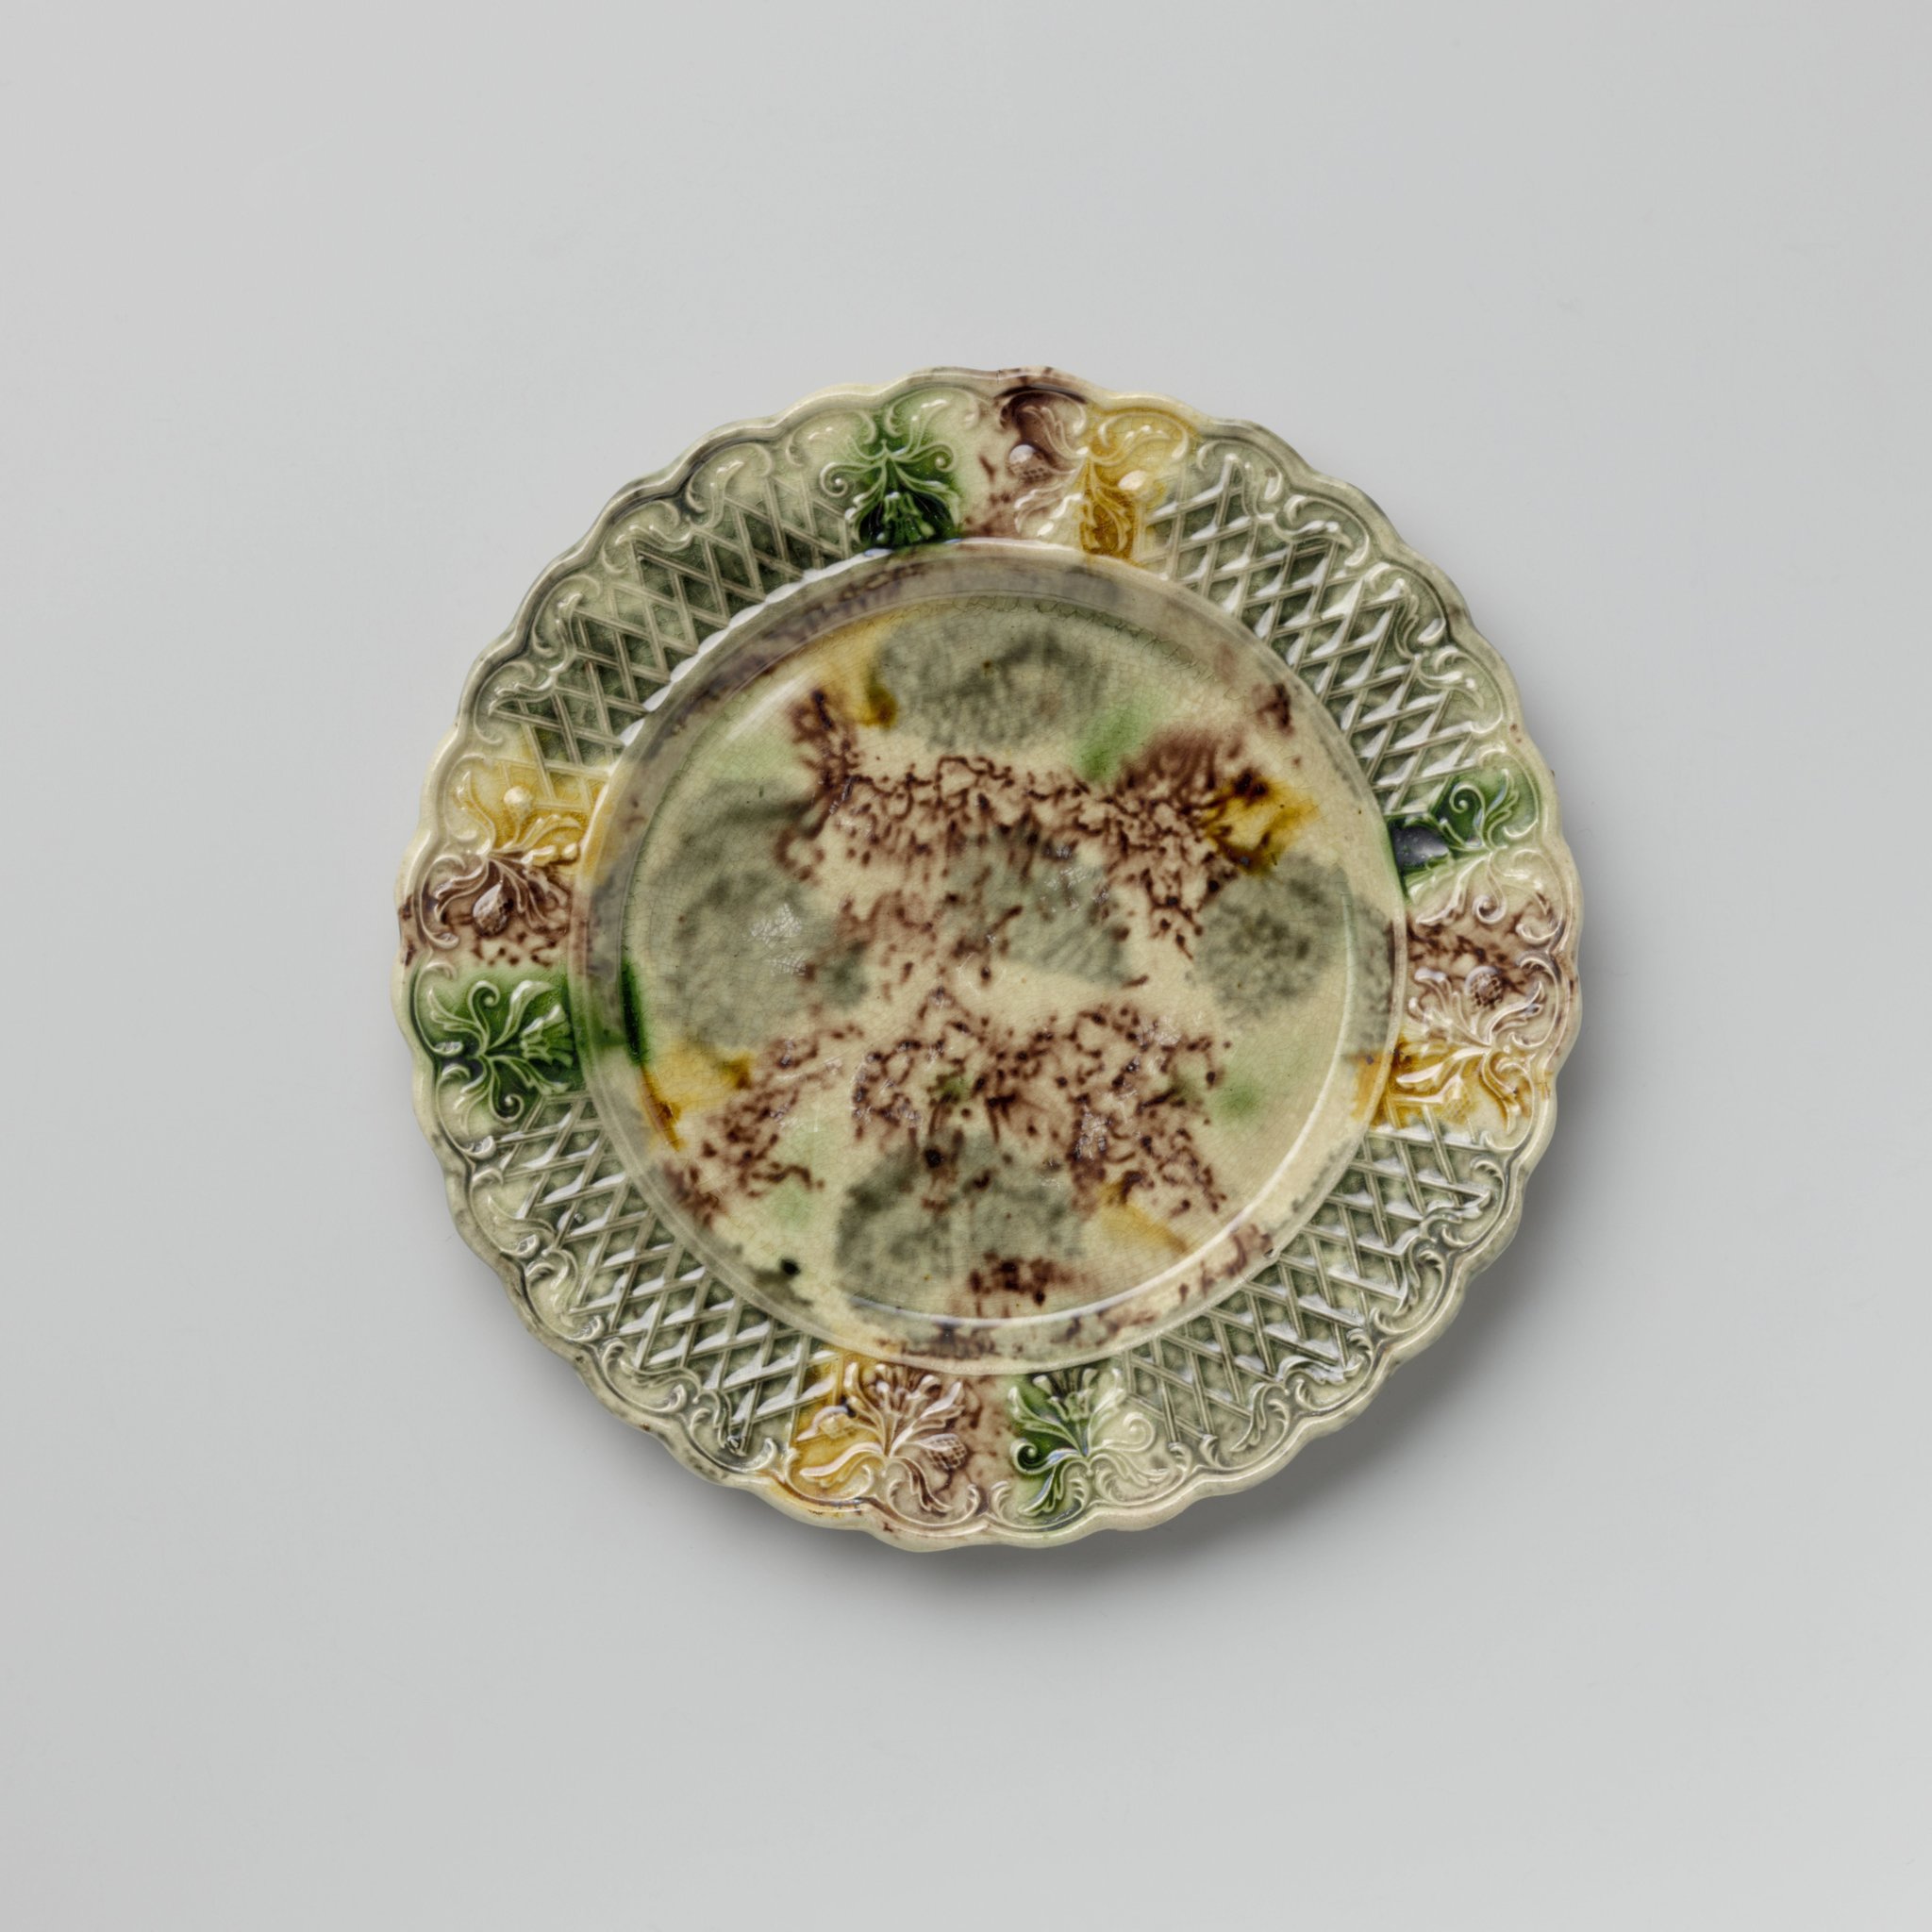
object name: plate dish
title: Bord van veelkleurig hardgebakken aardewerk; Staffordshire.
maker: Anonymous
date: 1750-1780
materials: earthenware, glaze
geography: england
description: Bord van veelkleurig hardgebakken aardewerk. De rand is in reliëf versierd met traliewerk, afgewisseld met twee naast elkaar geplaatste symmetrische bloemmotieven. De geschulpte rand is aan de binnenkant versierd met voluten en bladmotieven. Het bord is bedekt met een gevlekte loodglazuur in mangaan, groen, grijs en geel. De achterkant is in mangaan gestippeld en heeft een voetrand. Het bord hoort bij vijf borden (BK-1987-39-A t/m BK-1987-39-F).